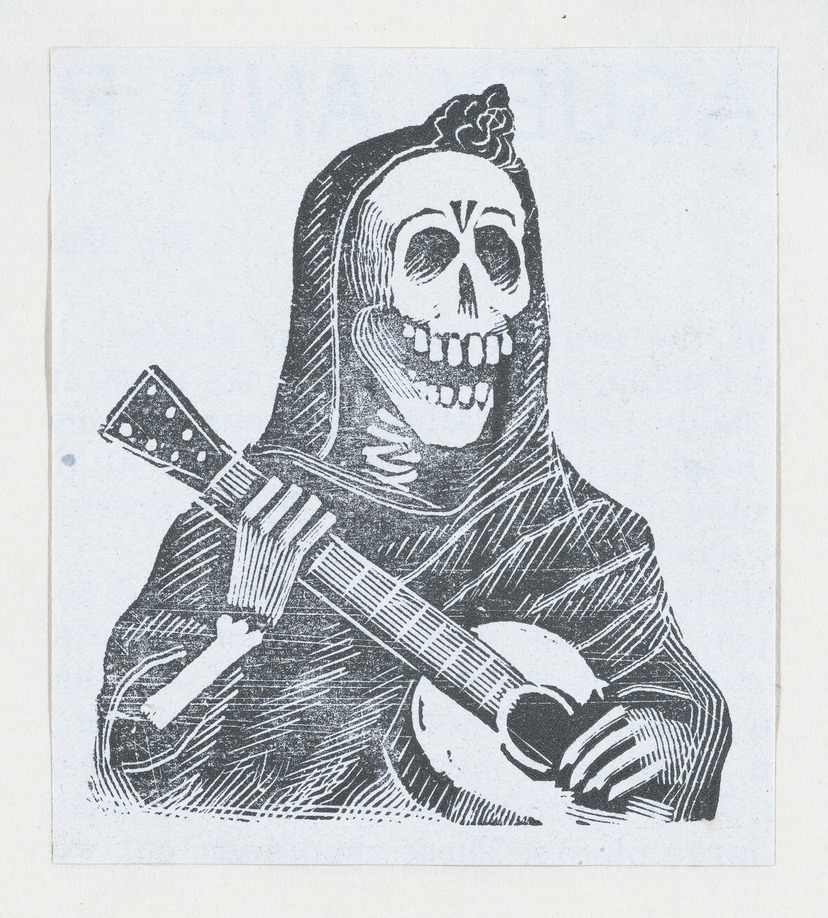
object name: print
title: Female skeleton playing the guitar (vignette for the feast of the dead)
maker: josé guadalupe posada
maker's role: artist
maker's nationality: mexican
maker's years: 1852-1913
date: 1890-1910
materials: metal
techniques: engraving, letterpress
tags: skeletons,guitars